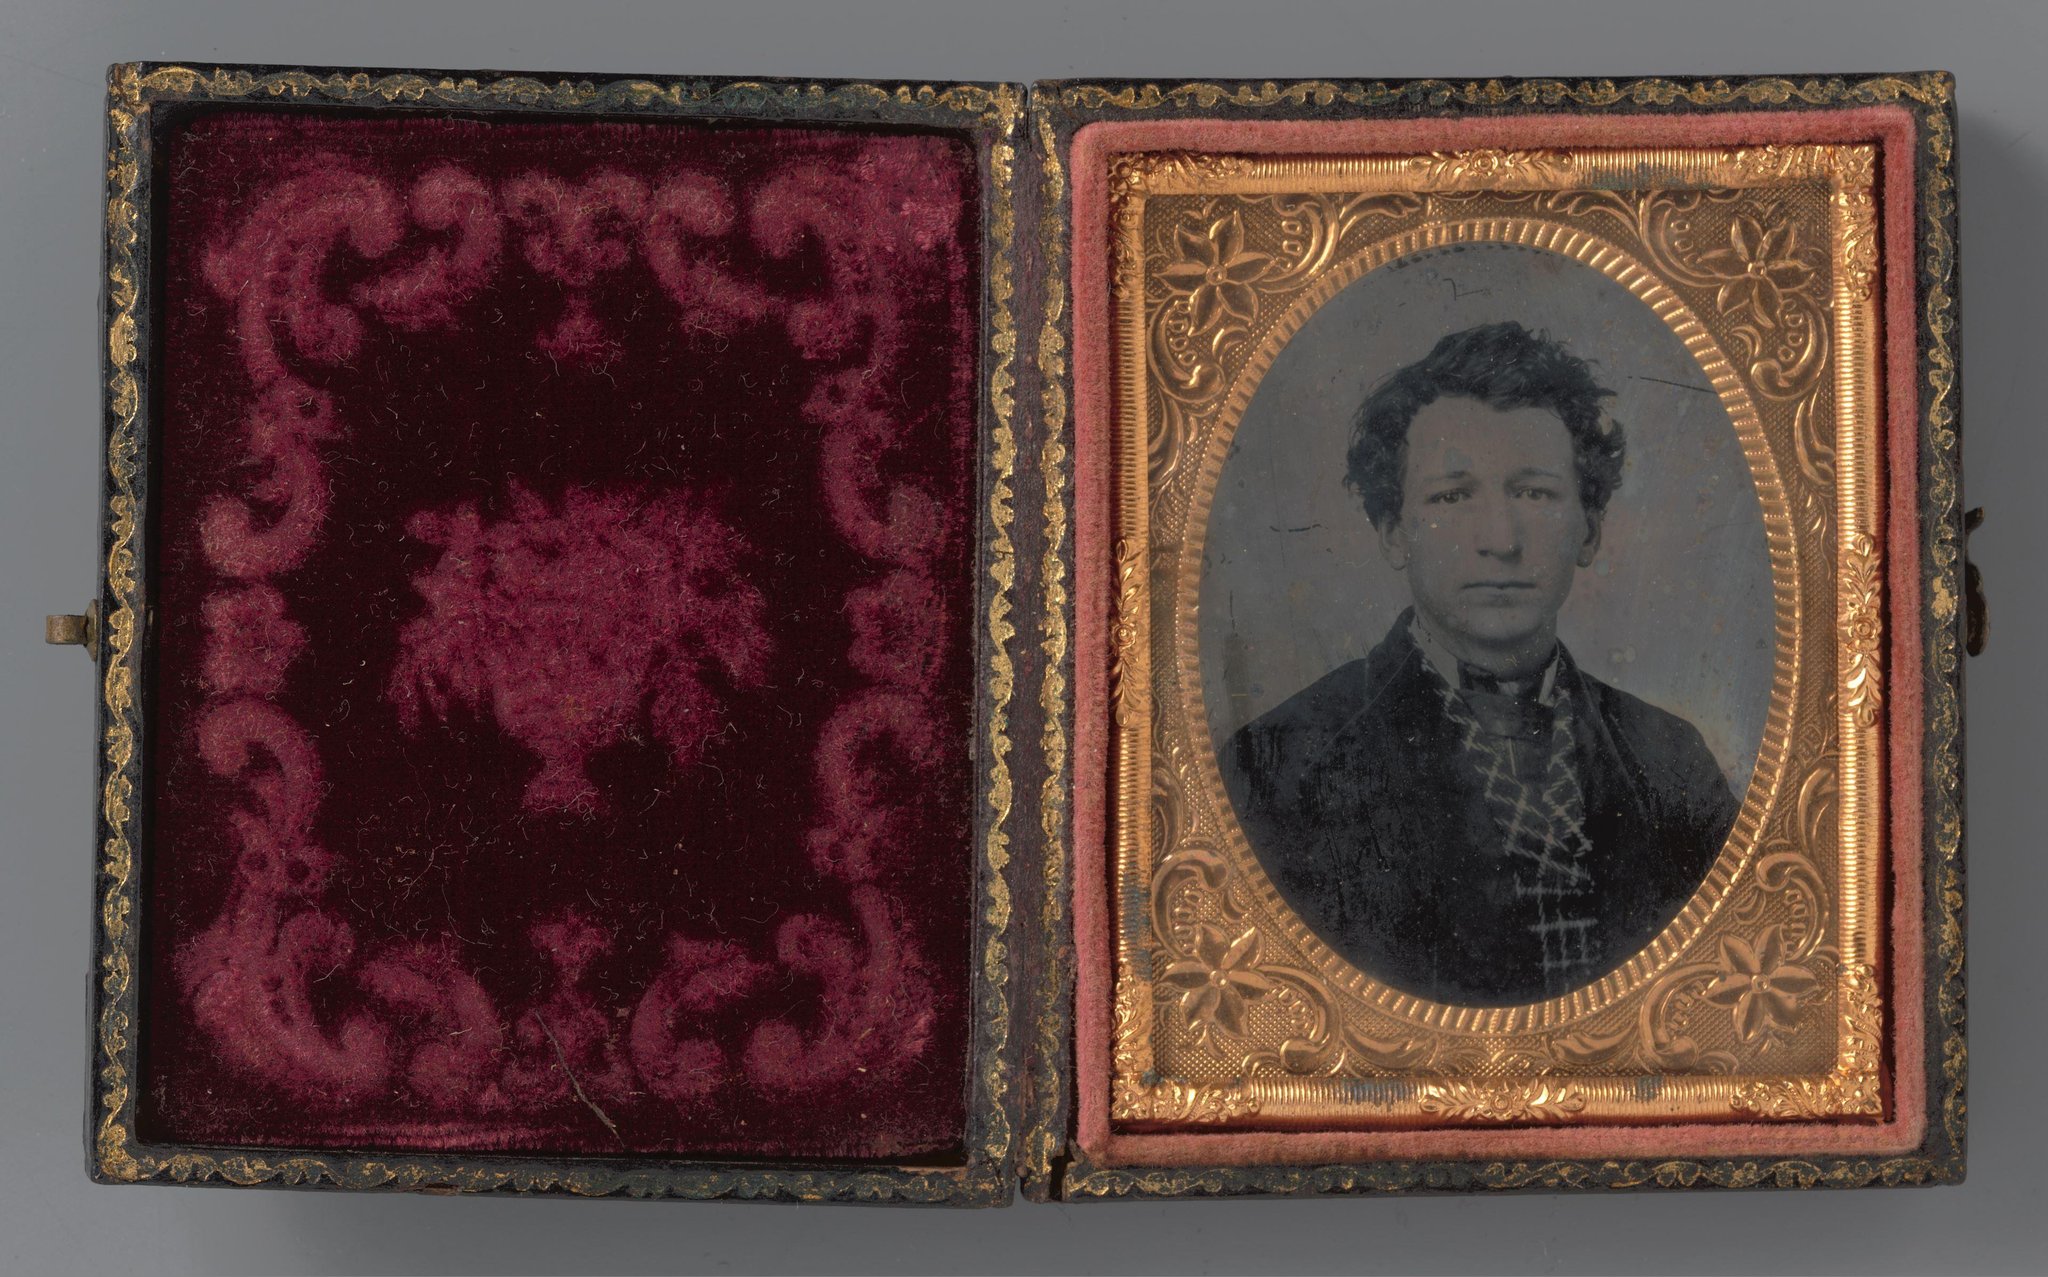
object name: photograph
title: Portret van een onbekende jonge man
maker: Anonymous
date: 1861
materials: glass, metal, velvet, wood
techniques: ambrotype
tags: historical persons, youth, adolescent